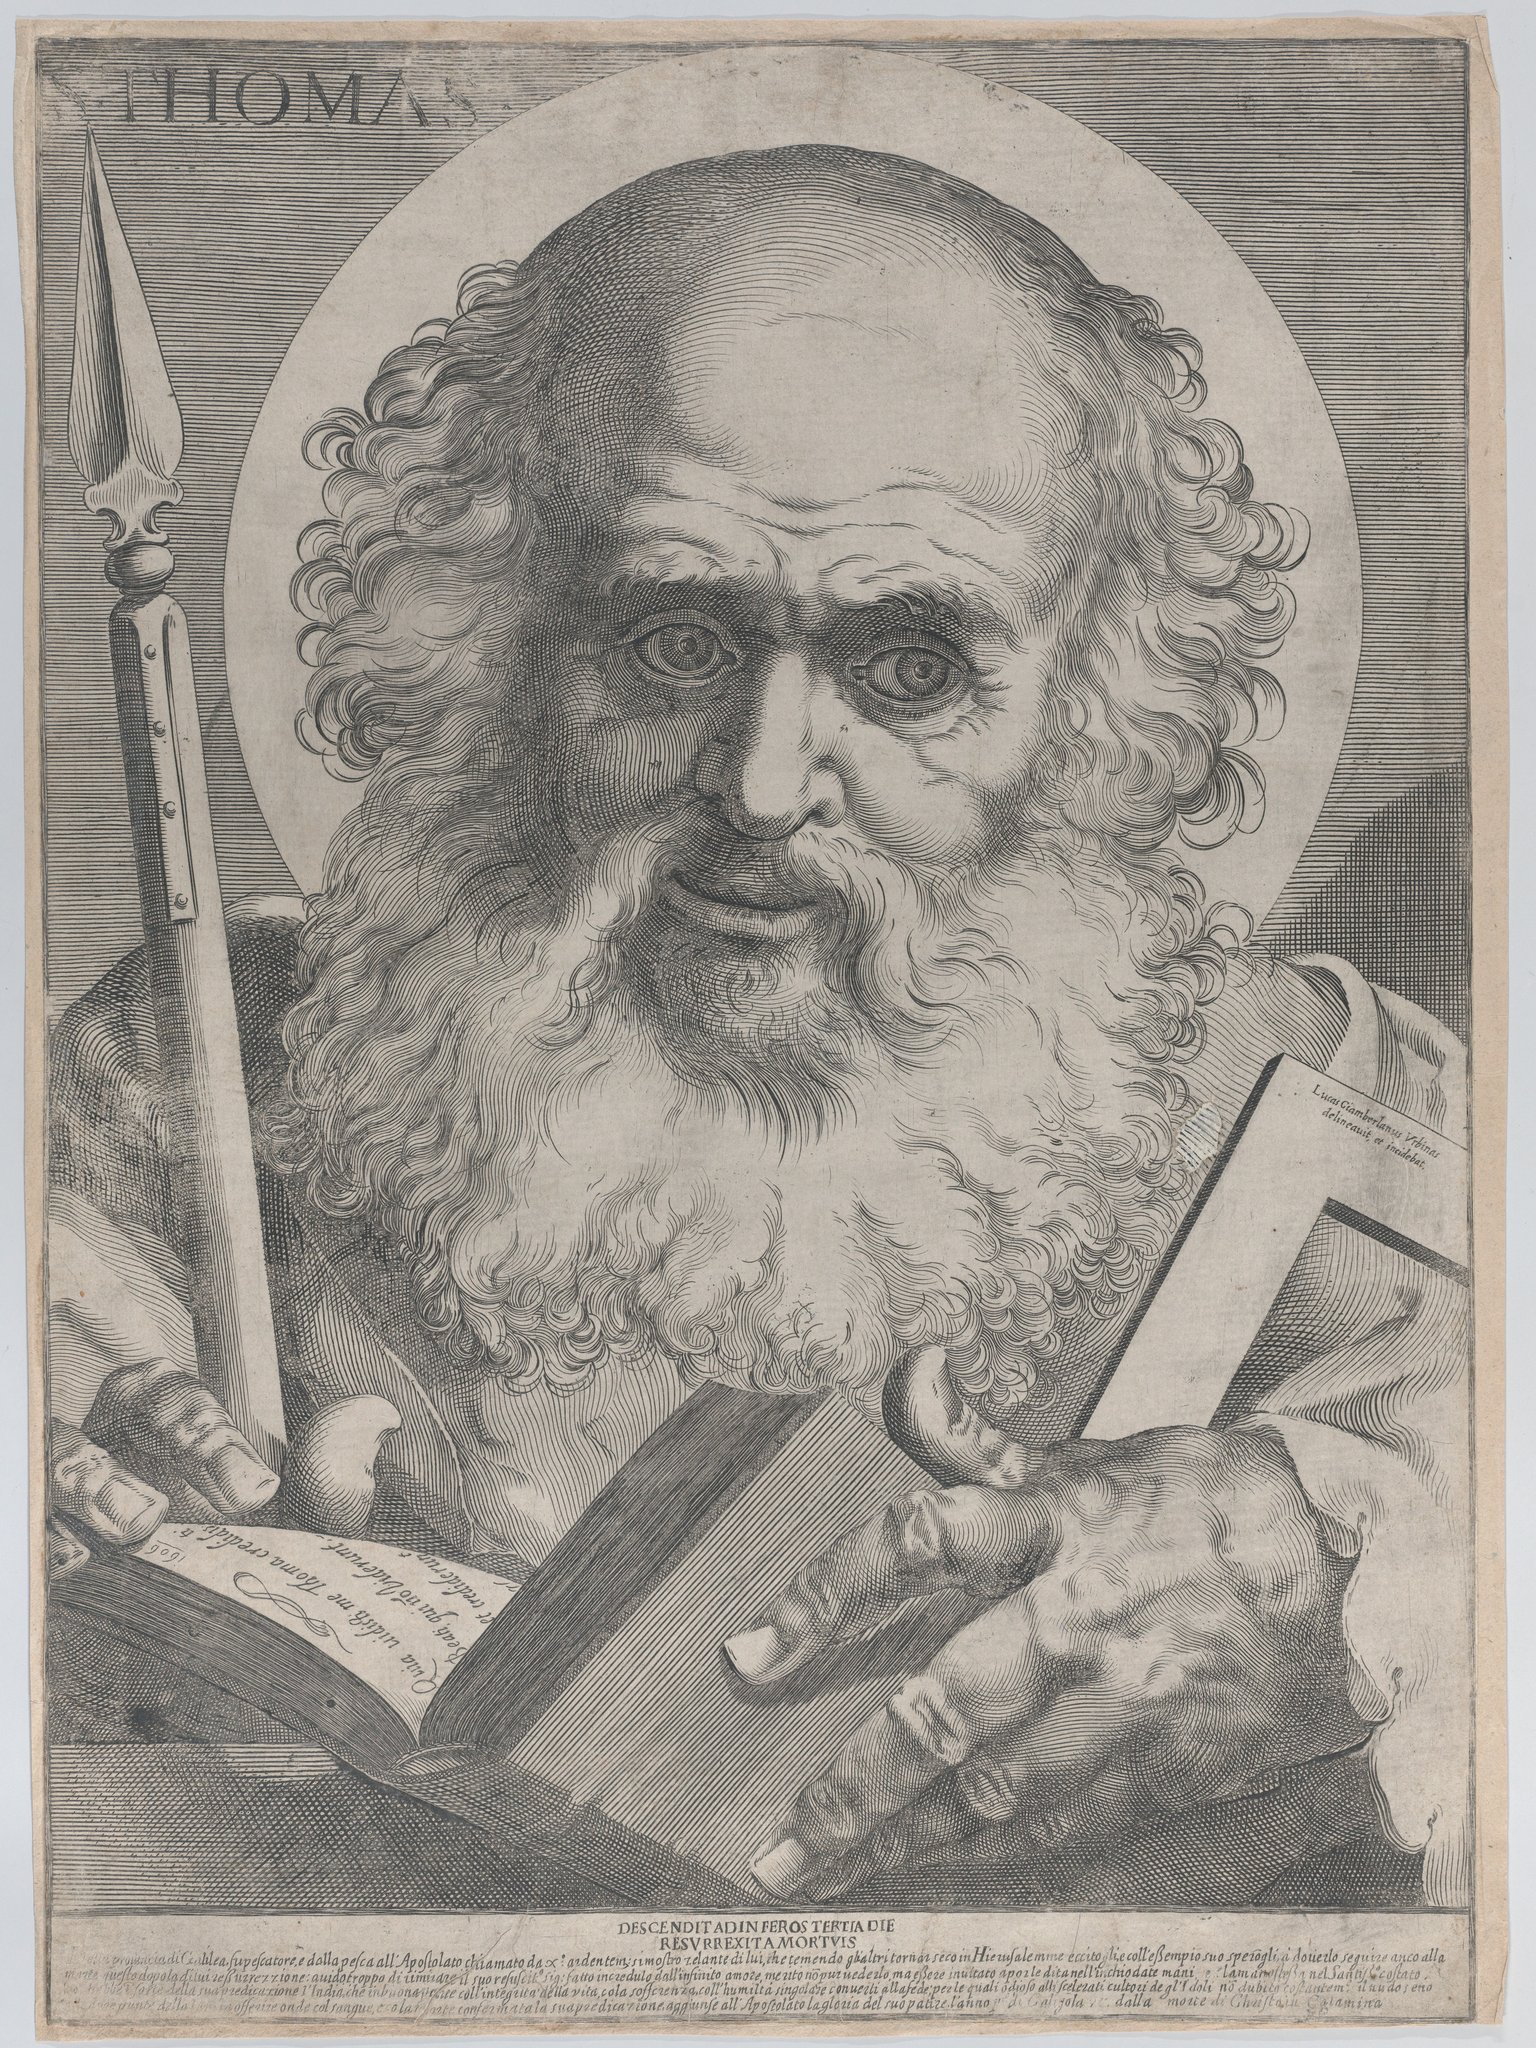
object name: print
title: Saint Thomas, with a lance in a right hand and a book and square in his left hand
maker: luca ciamberlano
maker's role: artist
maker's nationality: italian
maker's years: 1599-1641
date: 1606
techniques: engraving